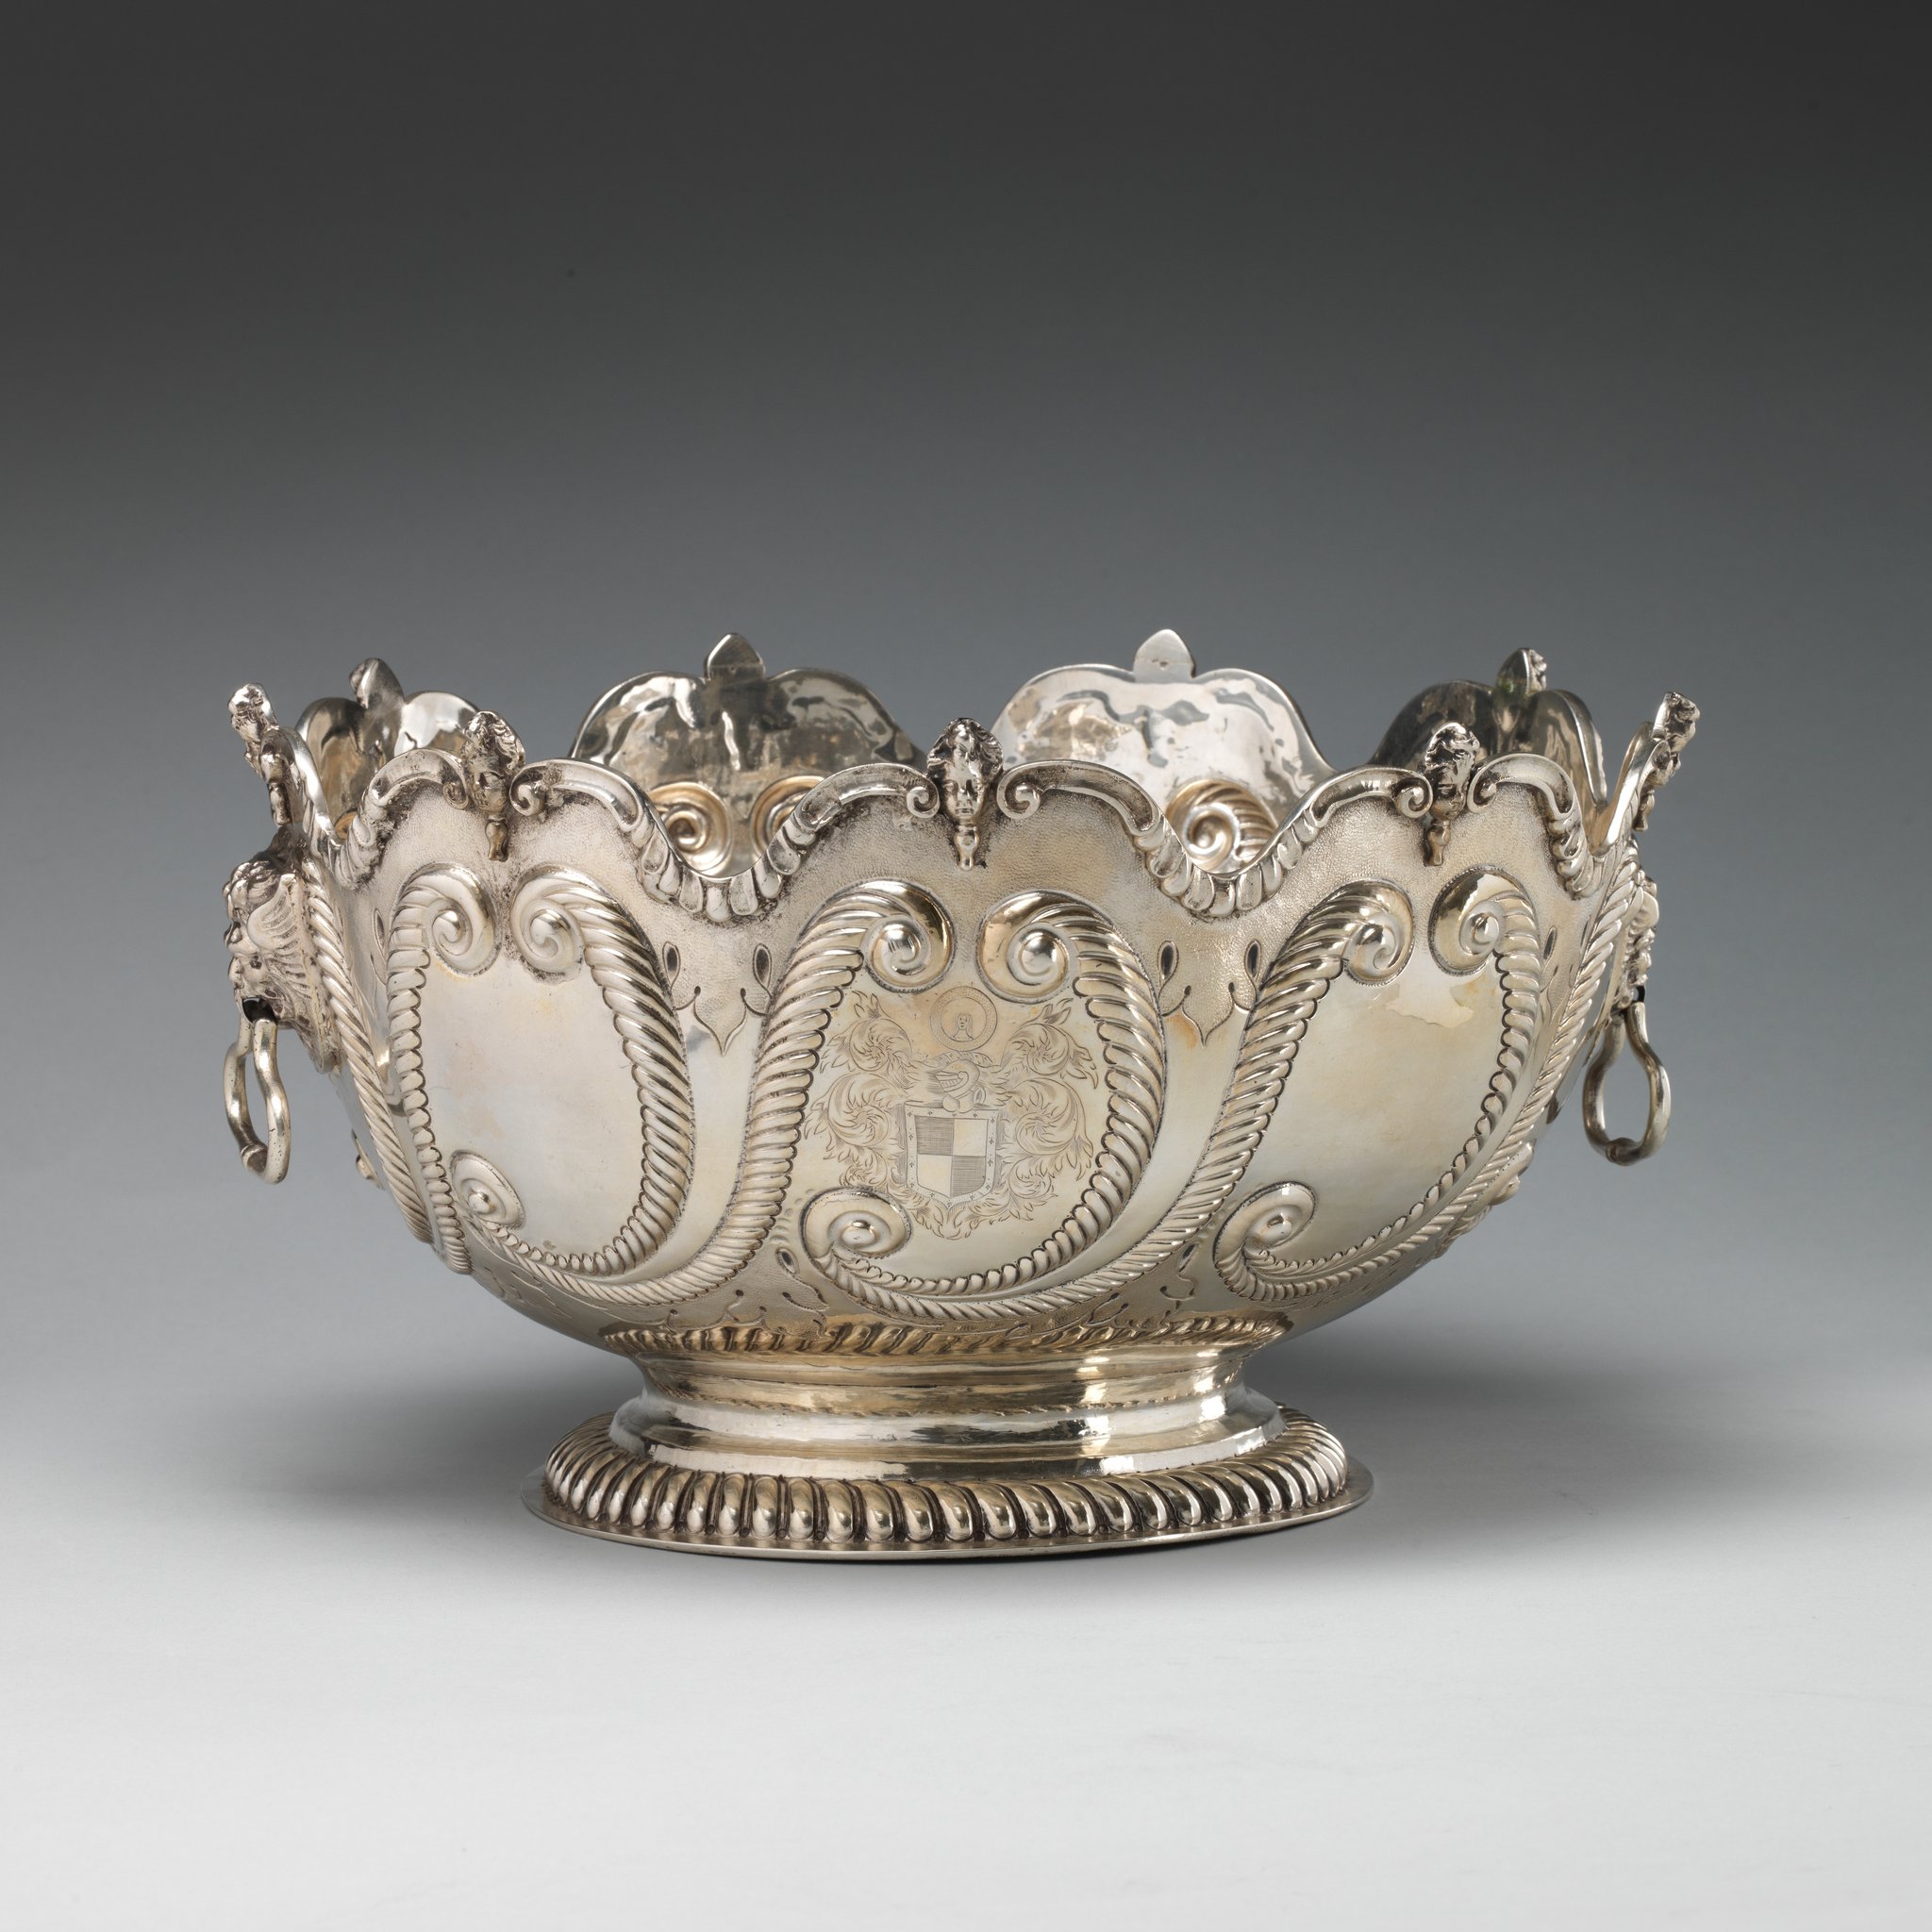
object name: monteith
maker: charles overing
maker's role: maker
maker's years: 1662-1722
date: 1695-1696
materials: silver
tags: coat of arms